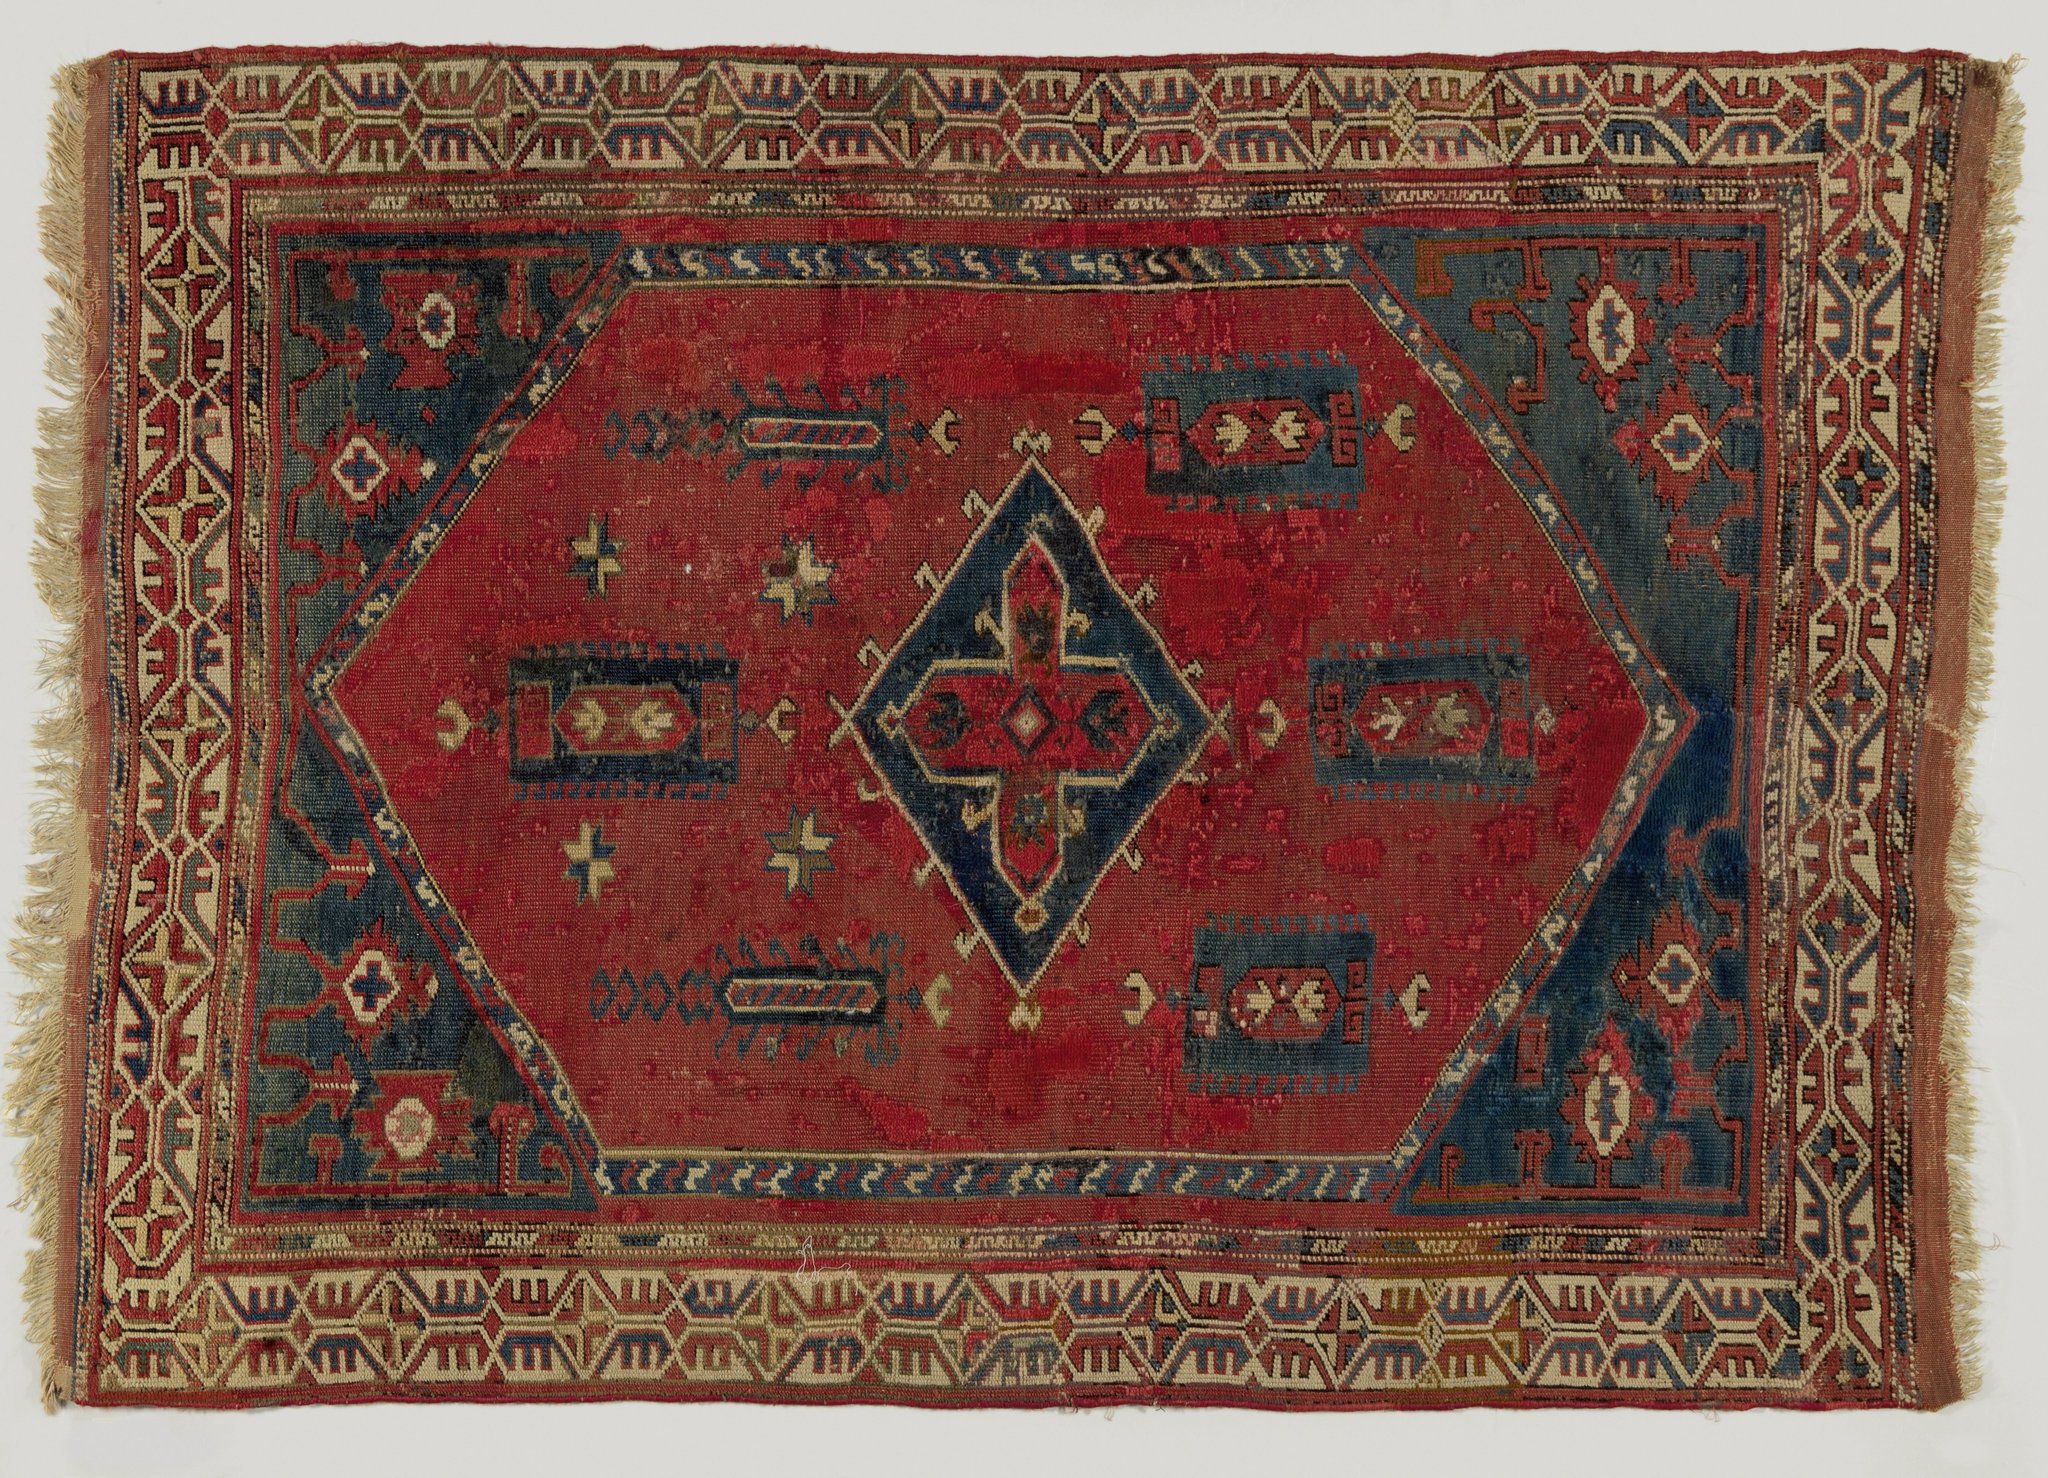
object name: oriental rug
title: Oosters tapijt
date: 1700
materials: cotton, wool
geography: asia minor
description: Oosters tapijt met in het midden op het middenveld eem blauwe ruit op een rode grond. In de hoeken palmetachige motieven op een blauwen grond. De rand is versierd met geometrische ruiten waarin een kruis.